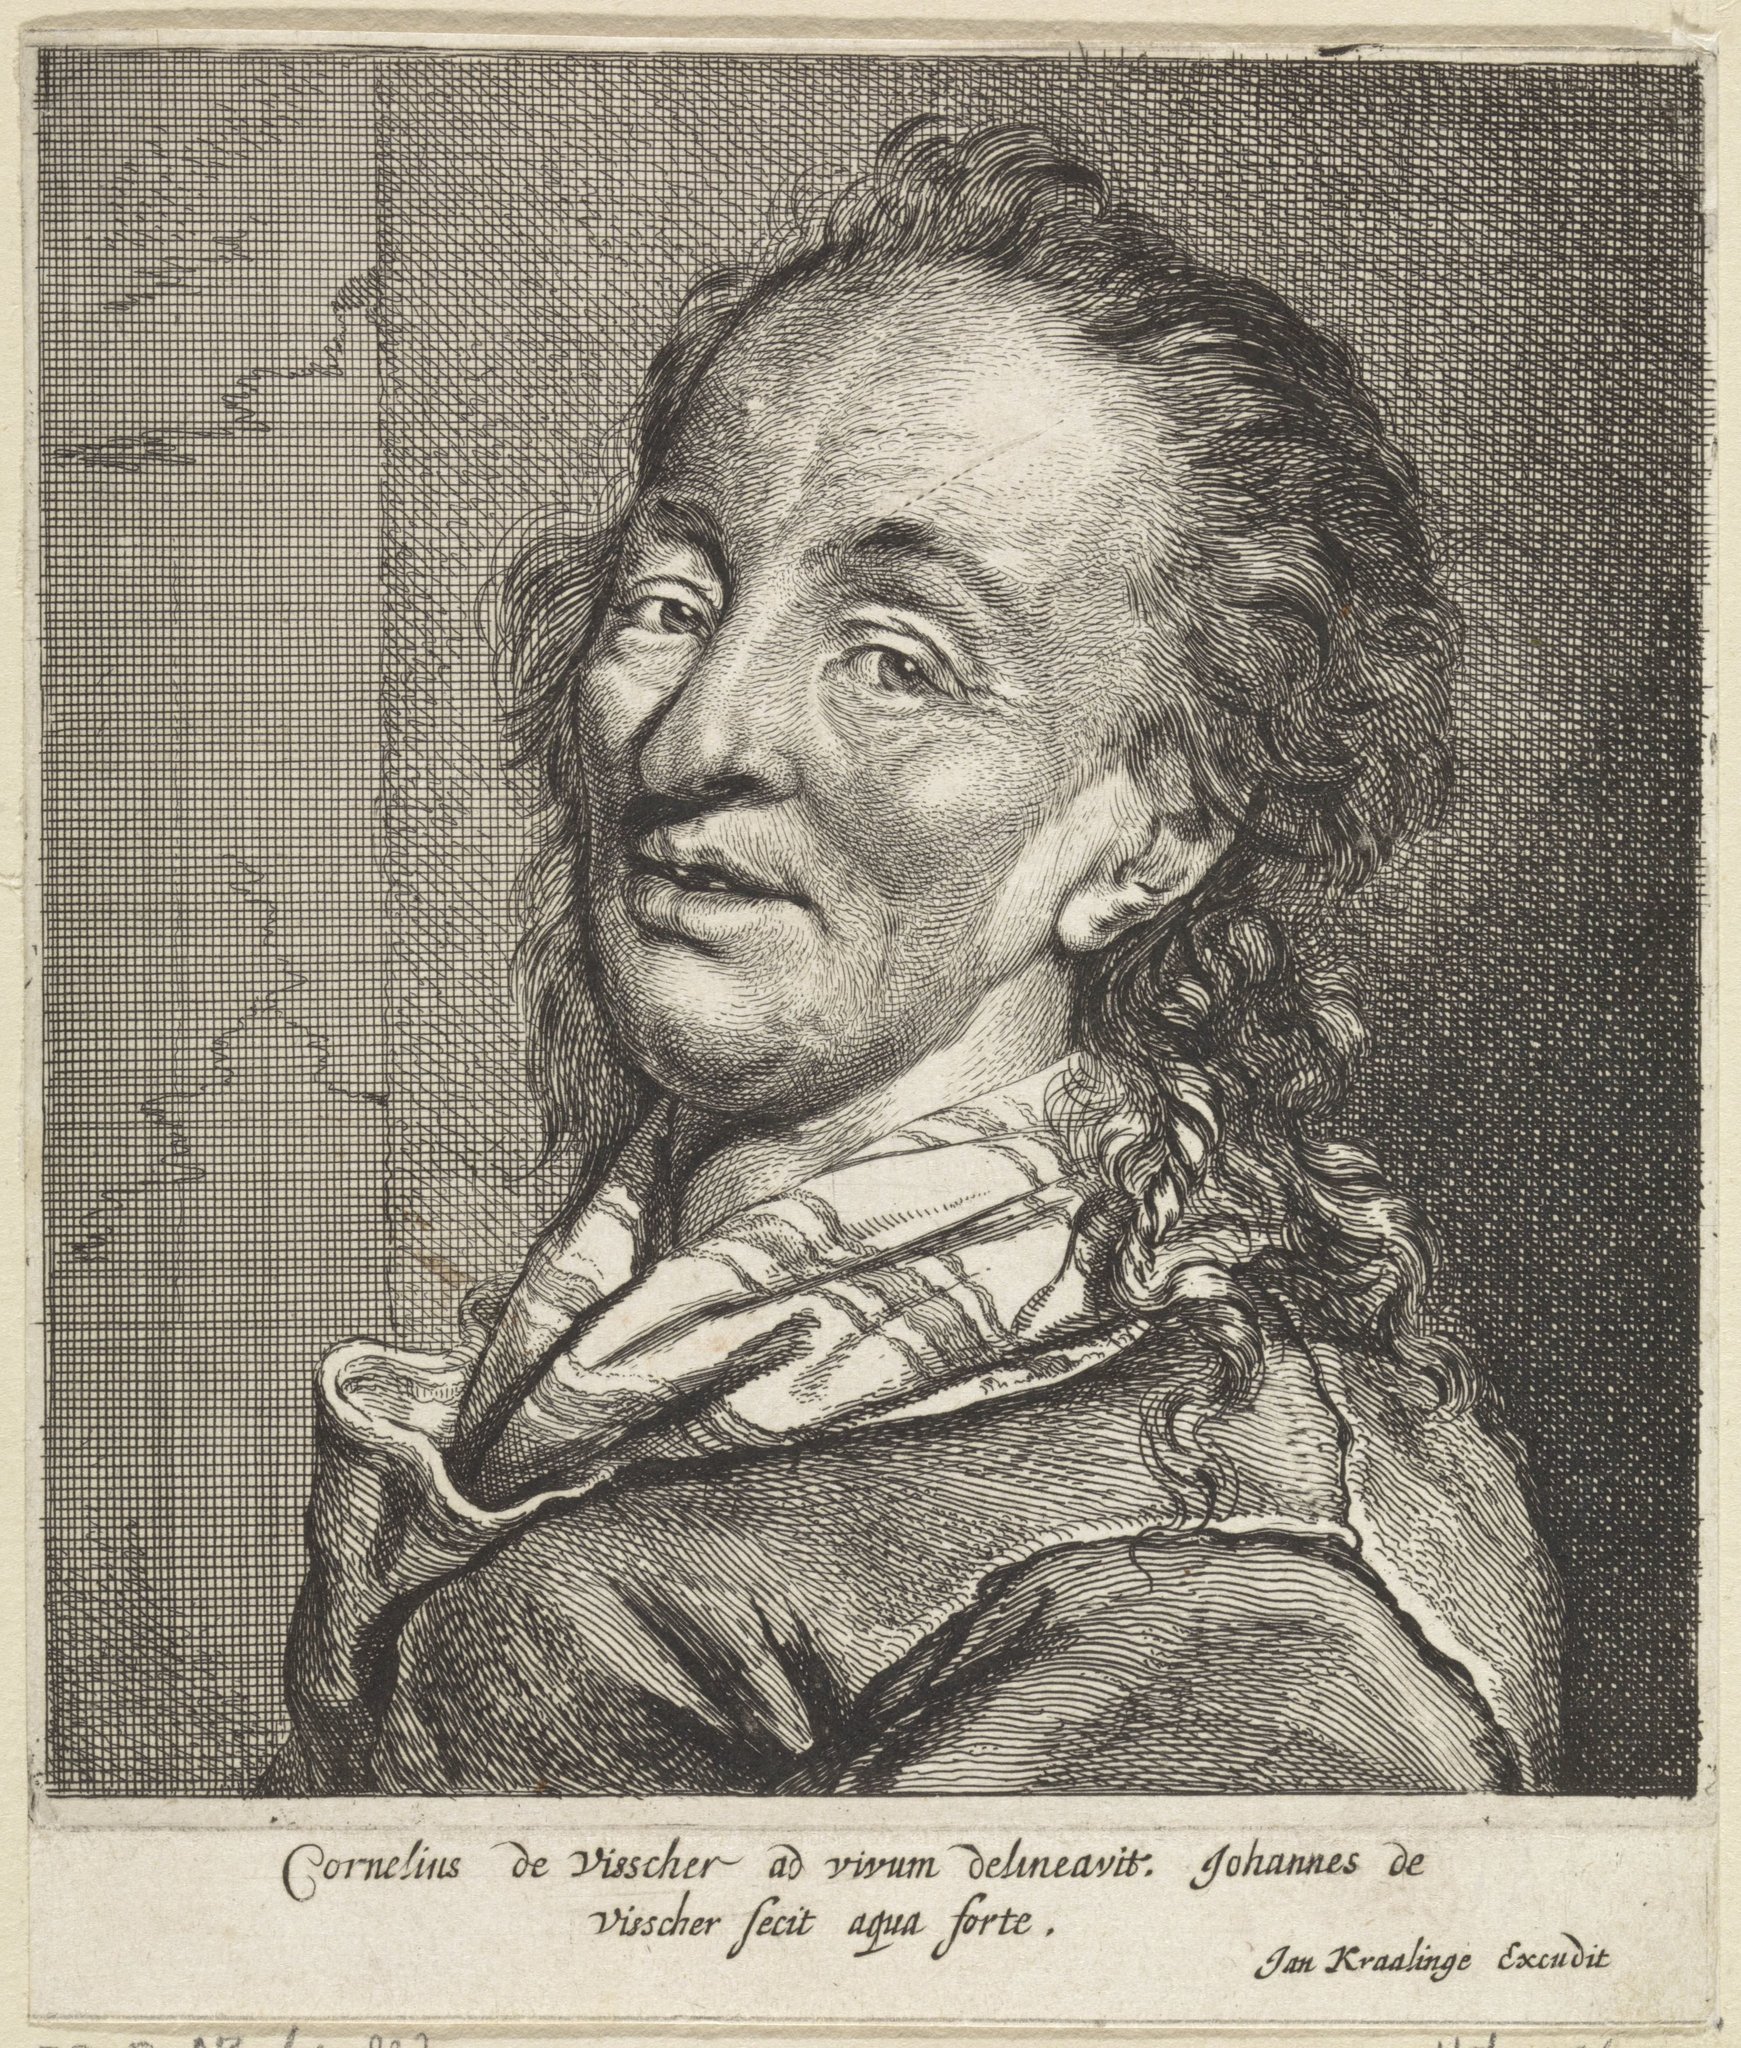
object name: print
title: Buste van een vrouw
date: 1655-1673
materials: paper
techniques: etching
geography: amsterdam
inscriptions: collector's mark: Lugt 240